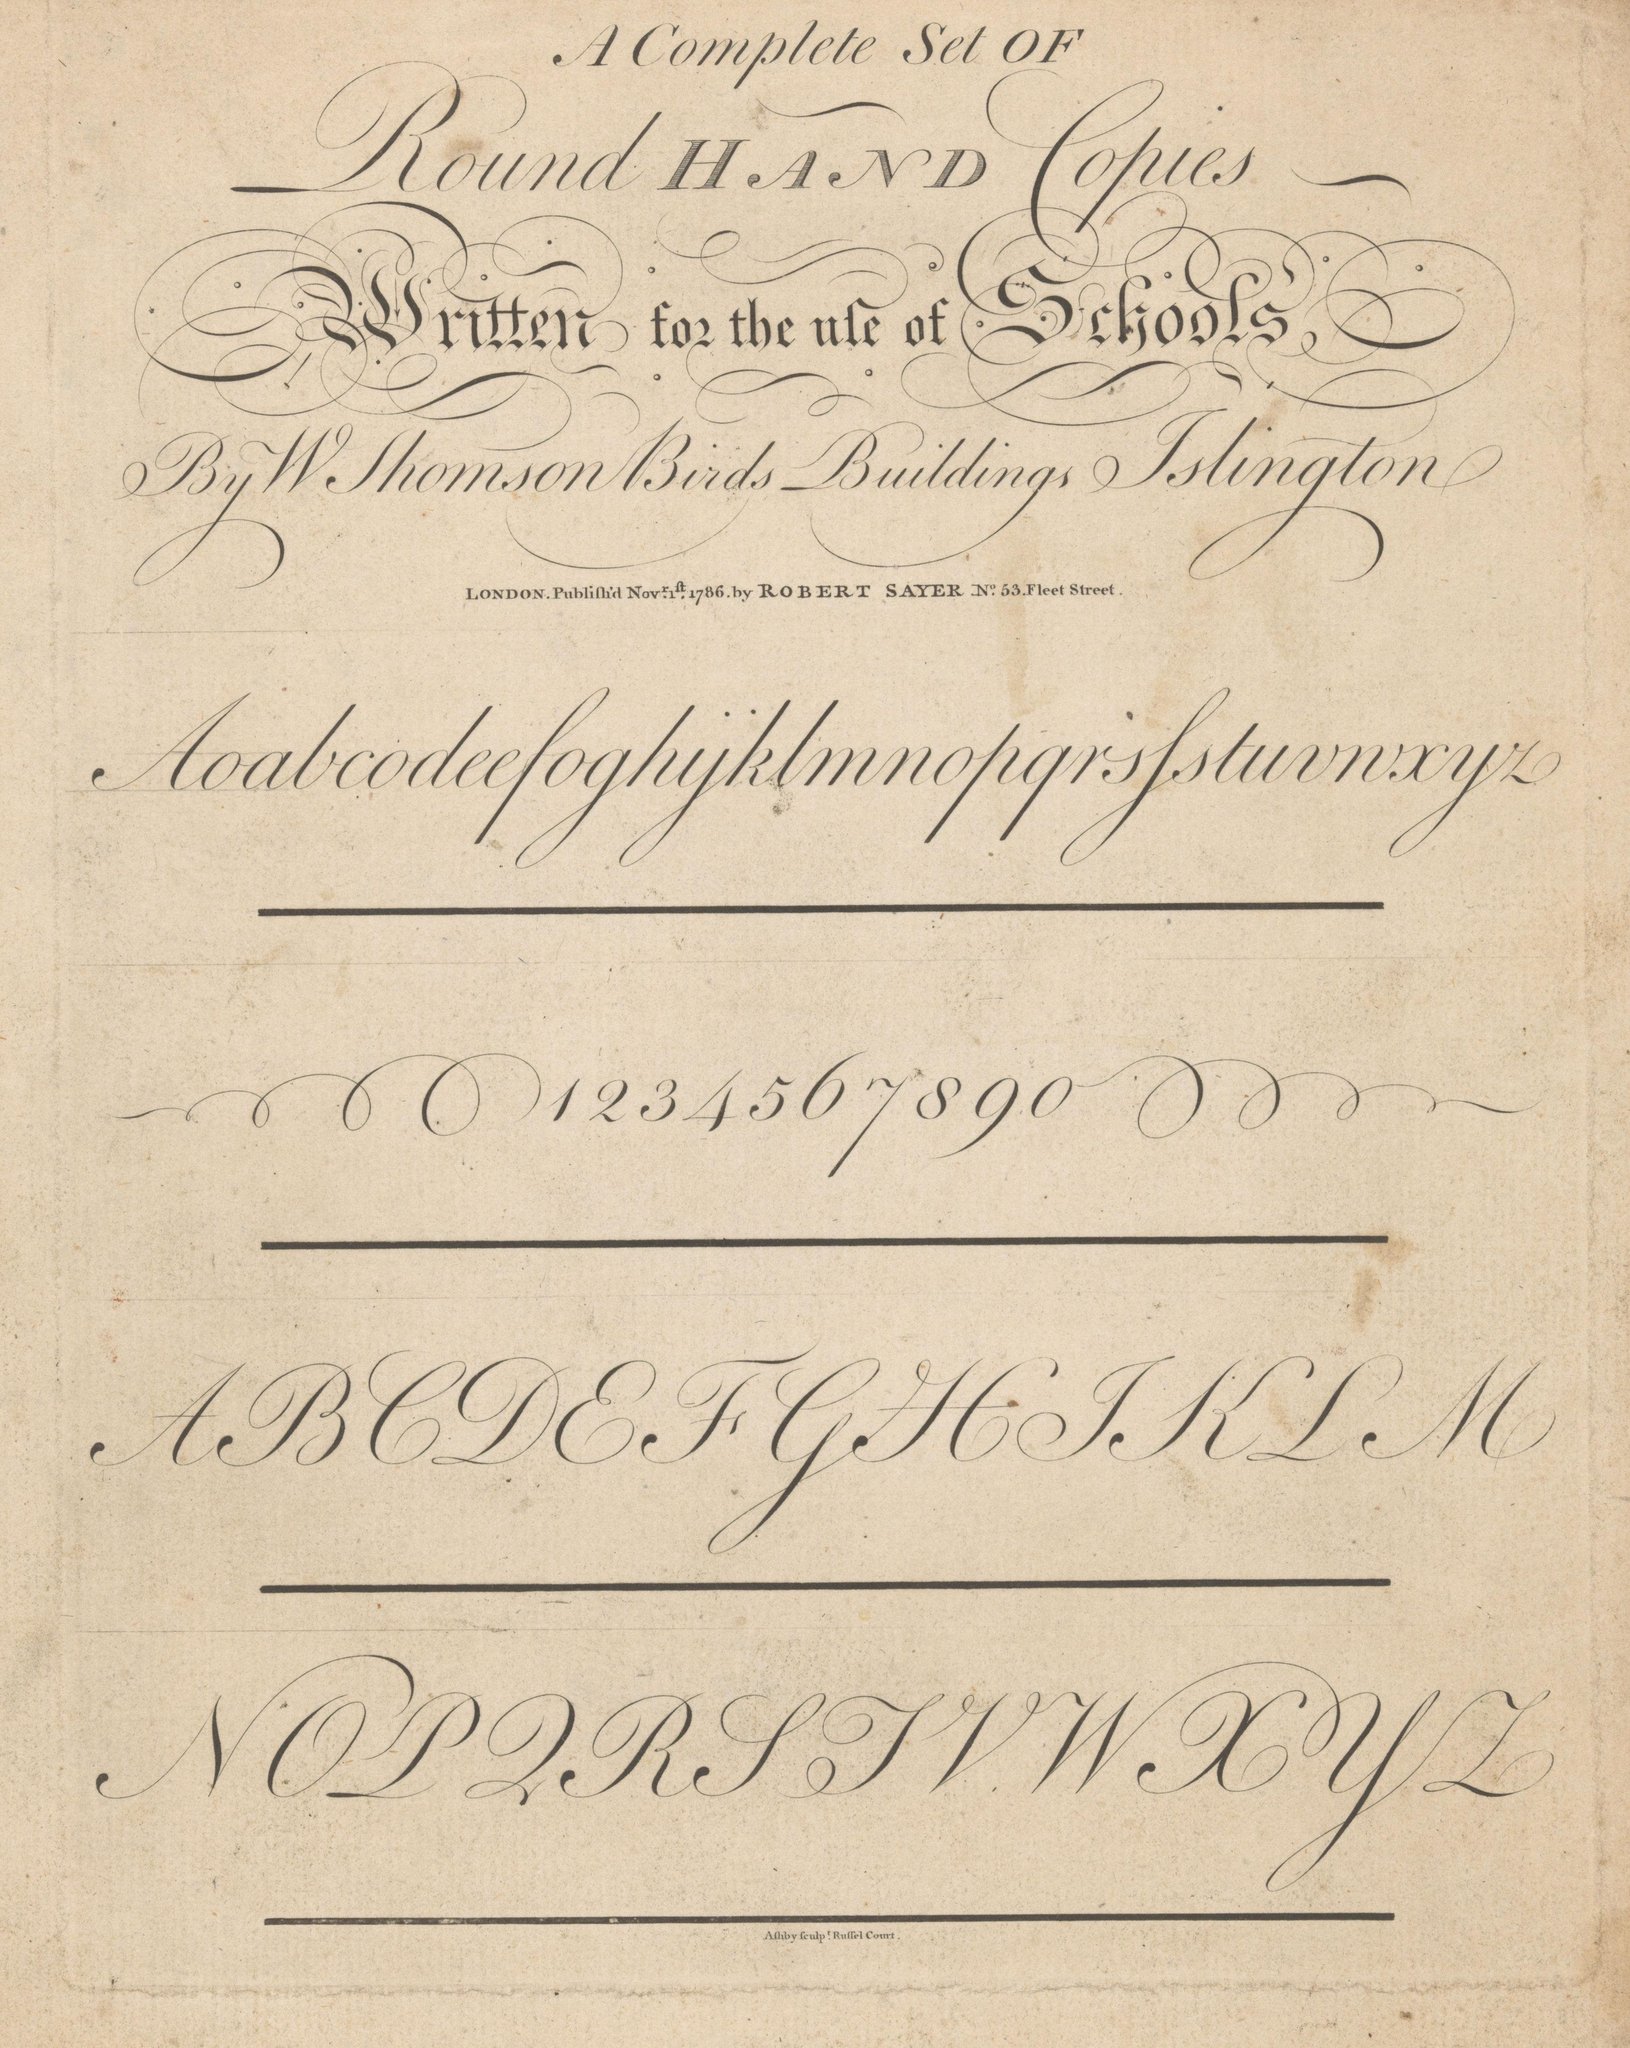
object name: ornament print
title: A Complete Set Of Round Hand Copies (...)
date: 1786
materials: paper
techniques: engraving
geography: london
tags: letters, alphabet, script, numerals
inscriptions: collector's mark: Lugt 2228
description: Het alfabet in kleine letters en kapitalen. Nummers 1 tot en met 0.